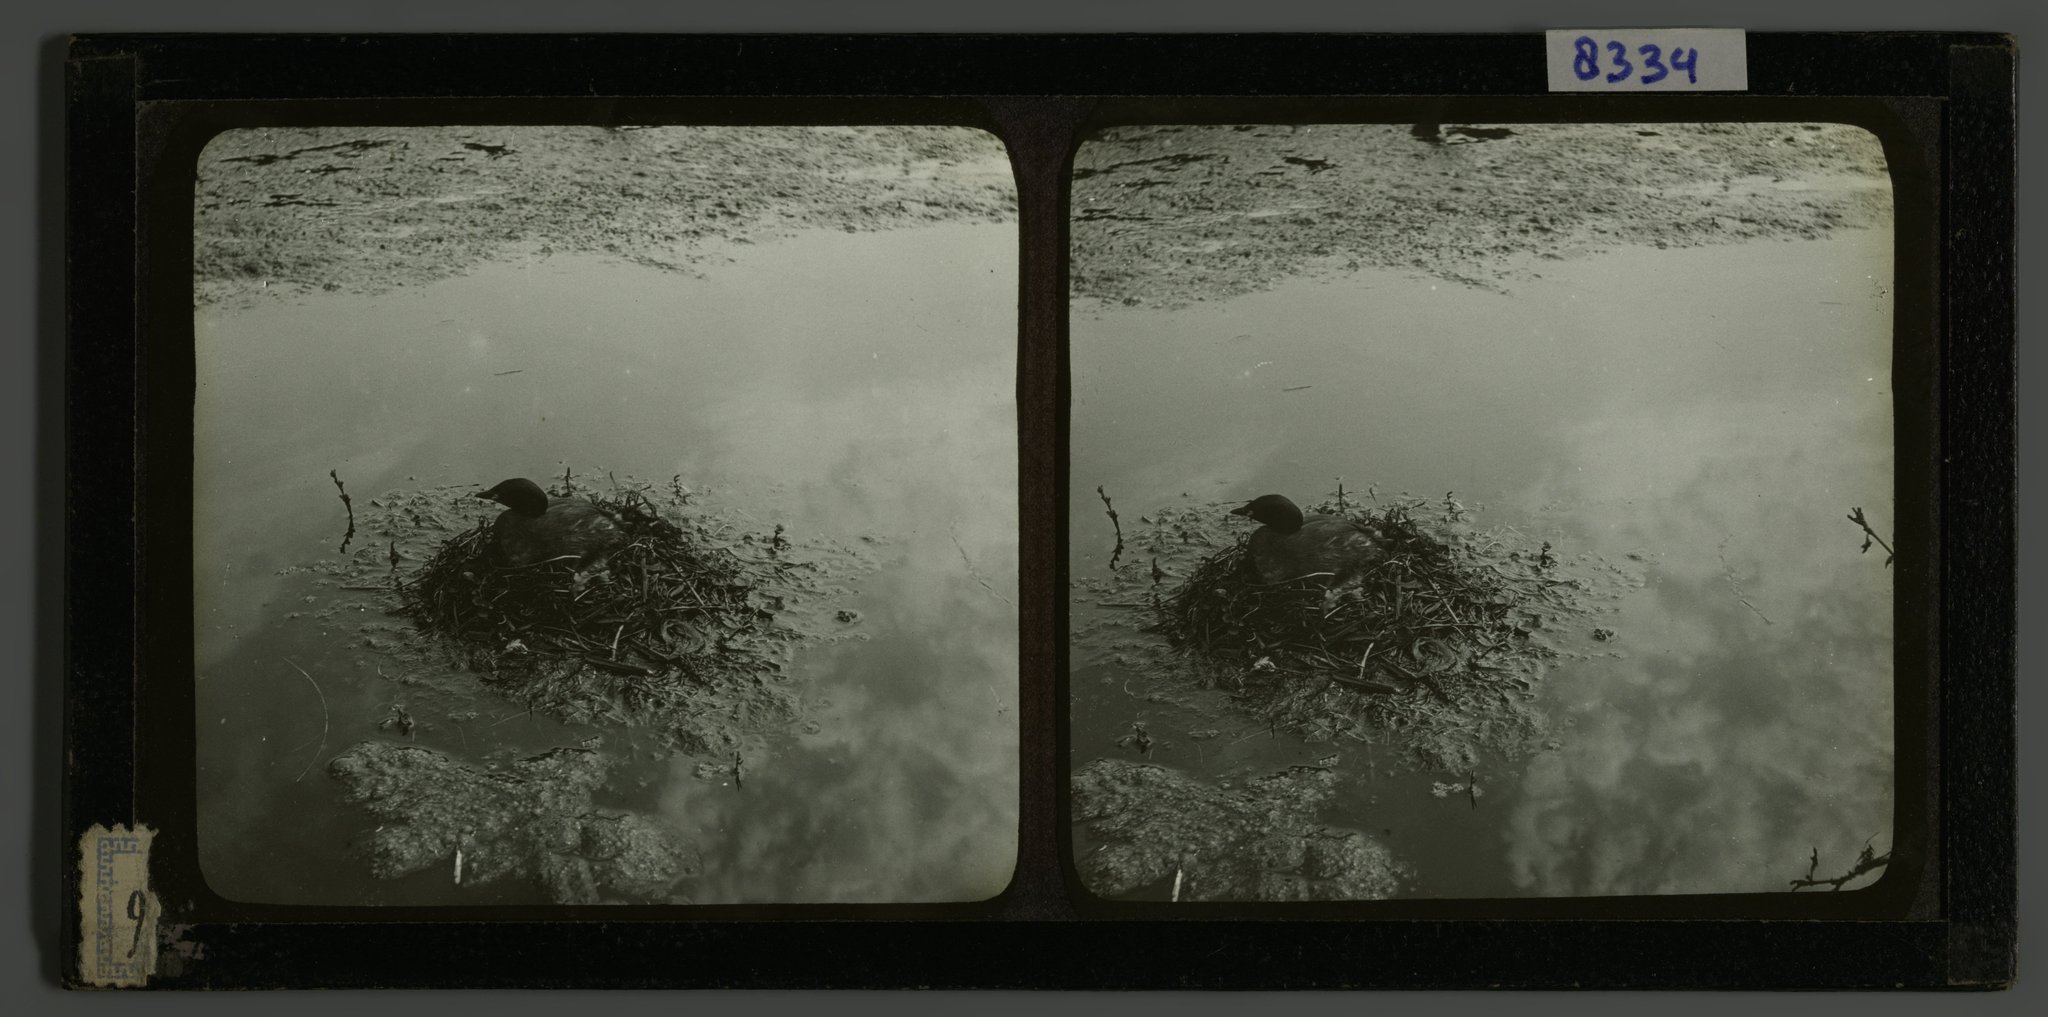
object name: stereoscopic photograph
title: Watervogel broedend op een nest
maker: Anonymous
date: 1856-1890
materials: glass, paper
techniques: slide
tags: water-birds (+ brooding, hatching)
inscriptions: number: ‘9’